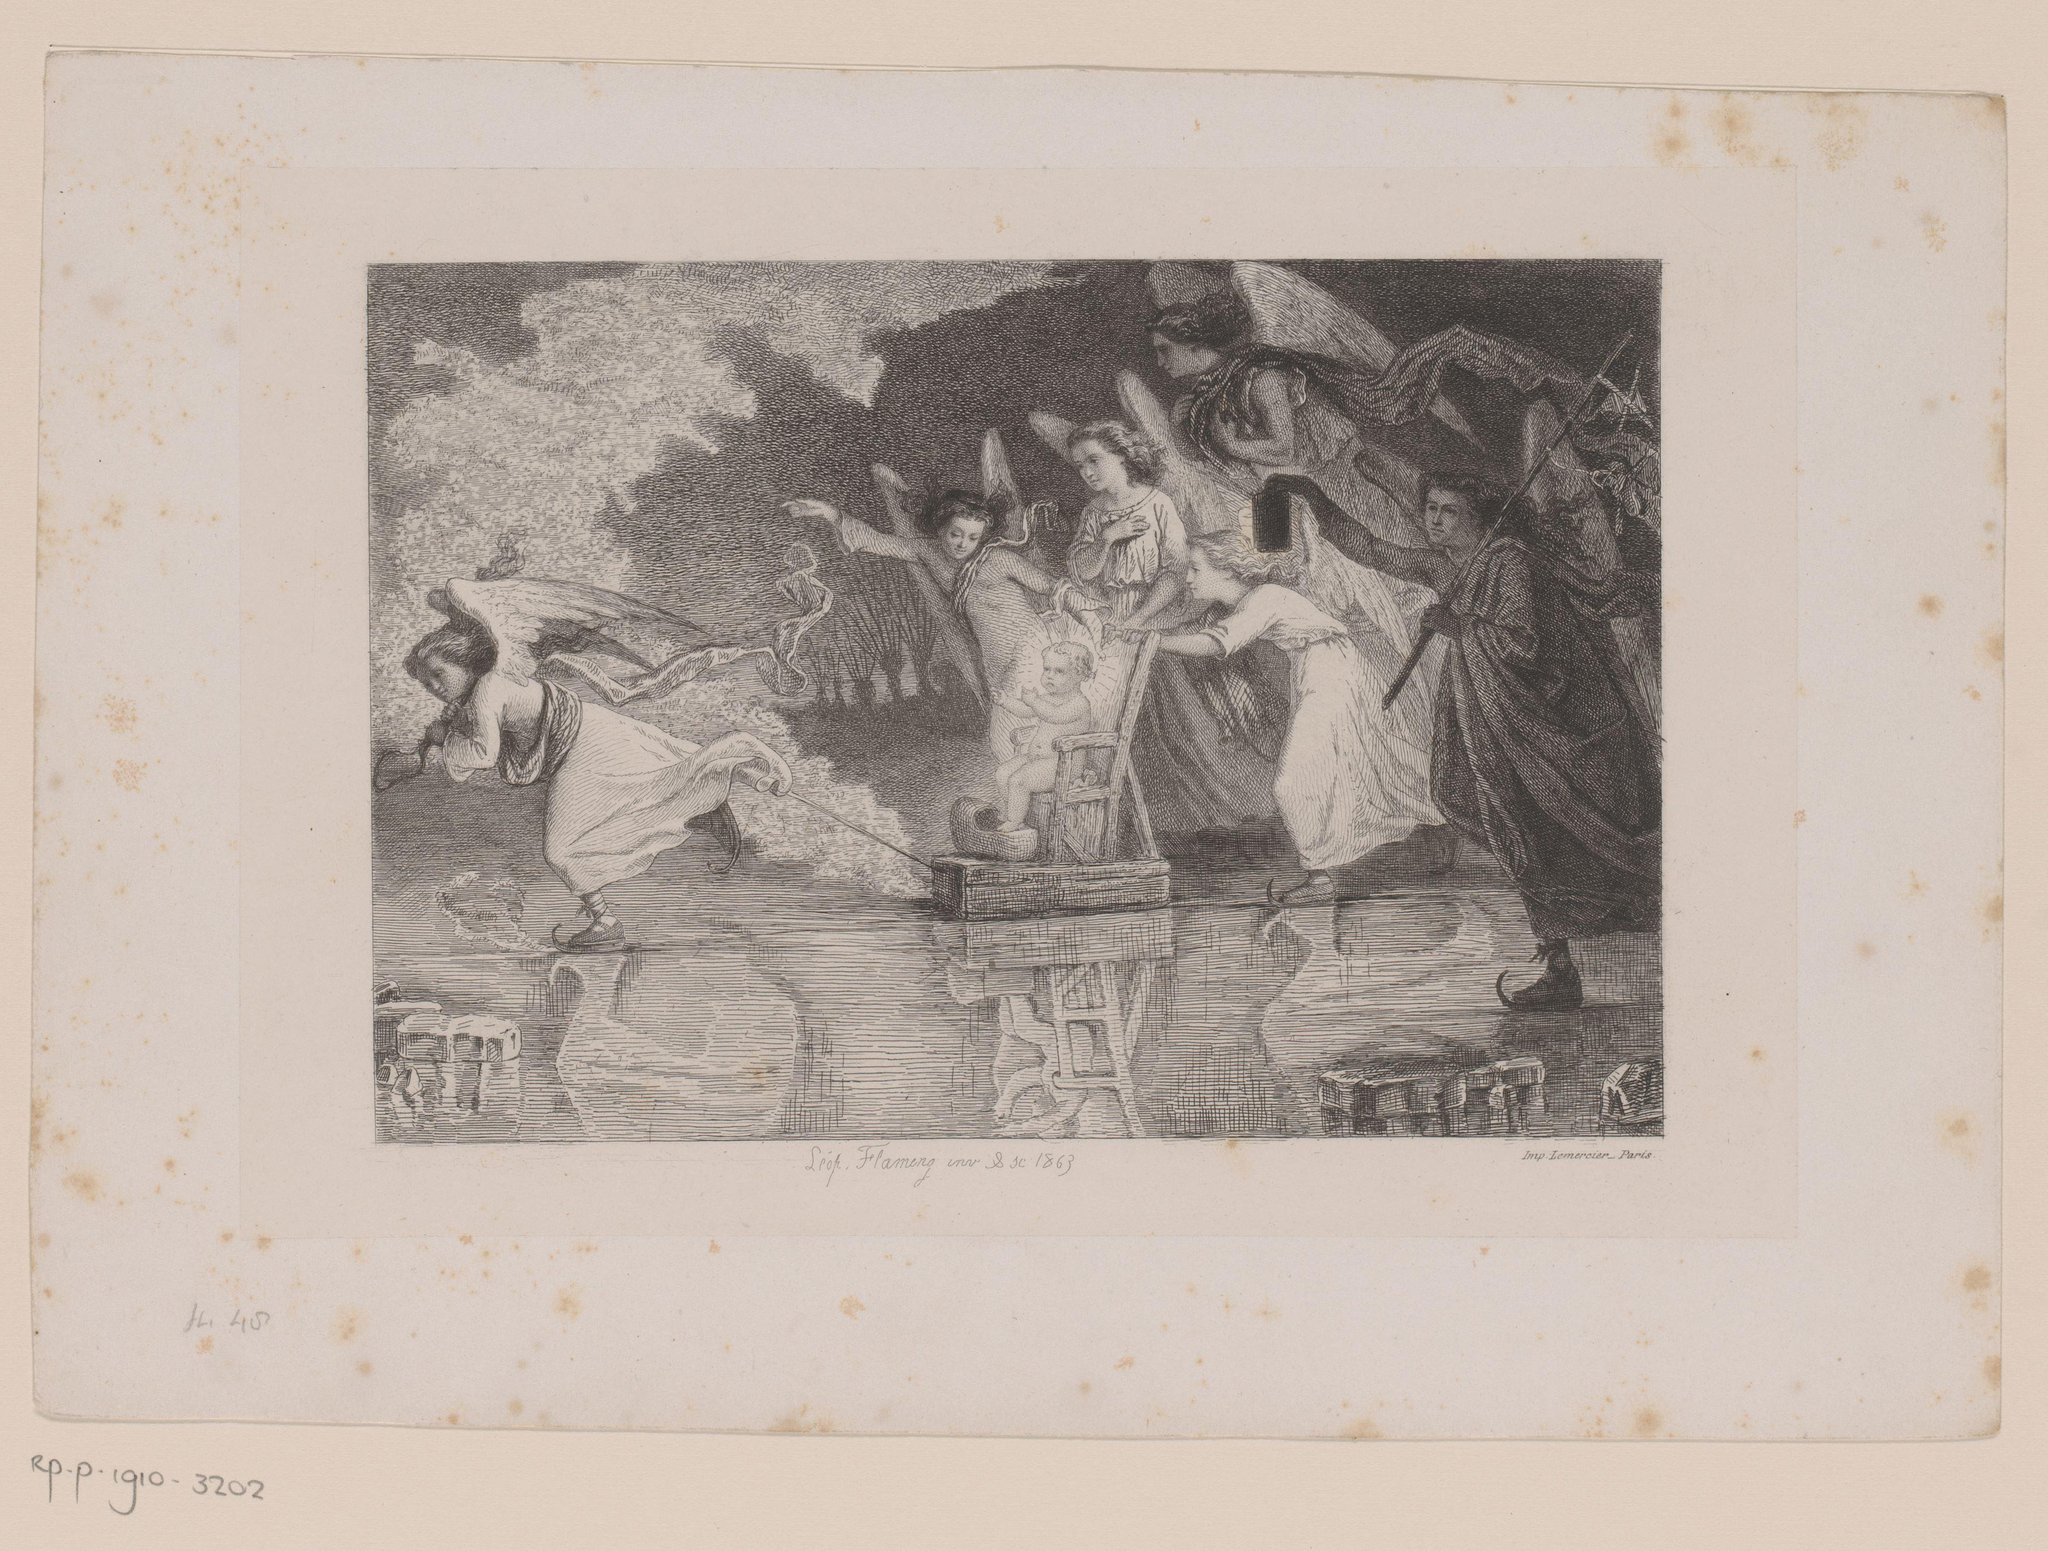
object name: print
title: Christus in een slee, over het ijs getrokken door schaatsende engelen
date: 1863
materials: paper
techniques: etching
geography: paris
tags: skates (winter sports), christ-child together with others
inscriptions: collector's mark: Lugt 2228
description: Prent uit: Giron, Aimé. Le sabot de Noël. Paris: Ducrocq, 1863, p. 42.